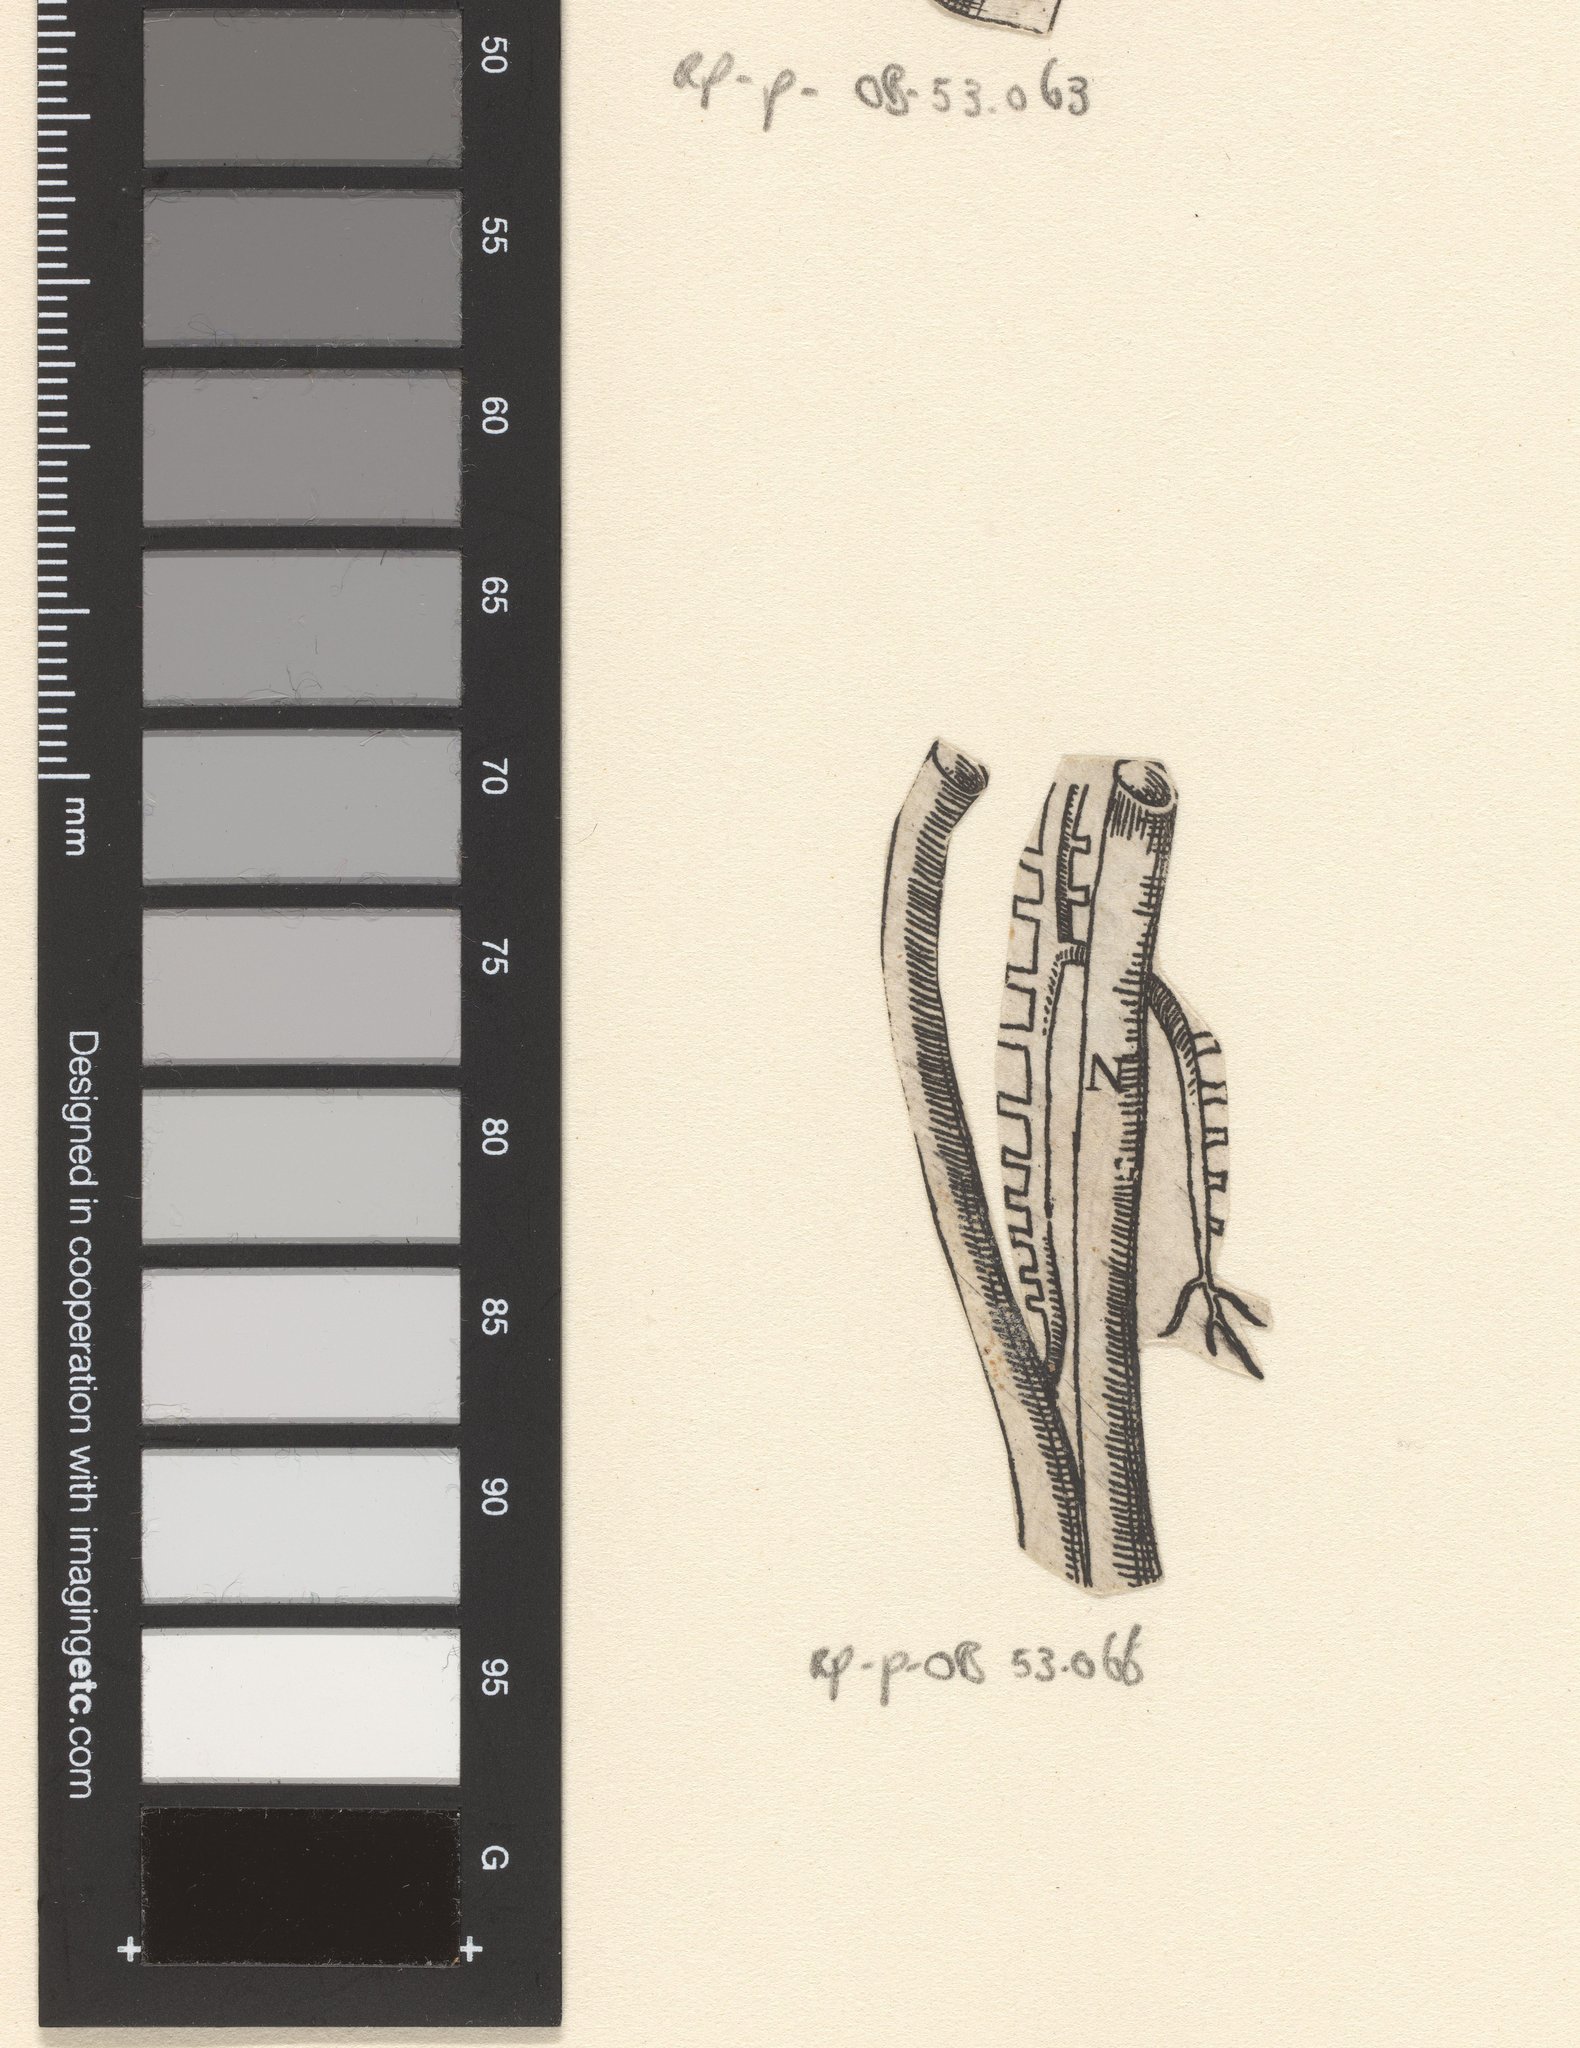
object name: print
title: Bloedvaten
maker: lucas kilian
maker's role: draughtsman, print maker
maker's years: 1579-1637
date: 1589-1637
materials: paper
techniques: etching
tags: arteries, organ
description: Suzanne Karr Schmidt suggereert dat deze prenten van losse en uitneembare (dus niet geplakte) organen onderdeel waren van de Visio Secundae en Visio Tertia van Johann Remmelin's 'Catoptrum Microcosmicum' uit 1619.